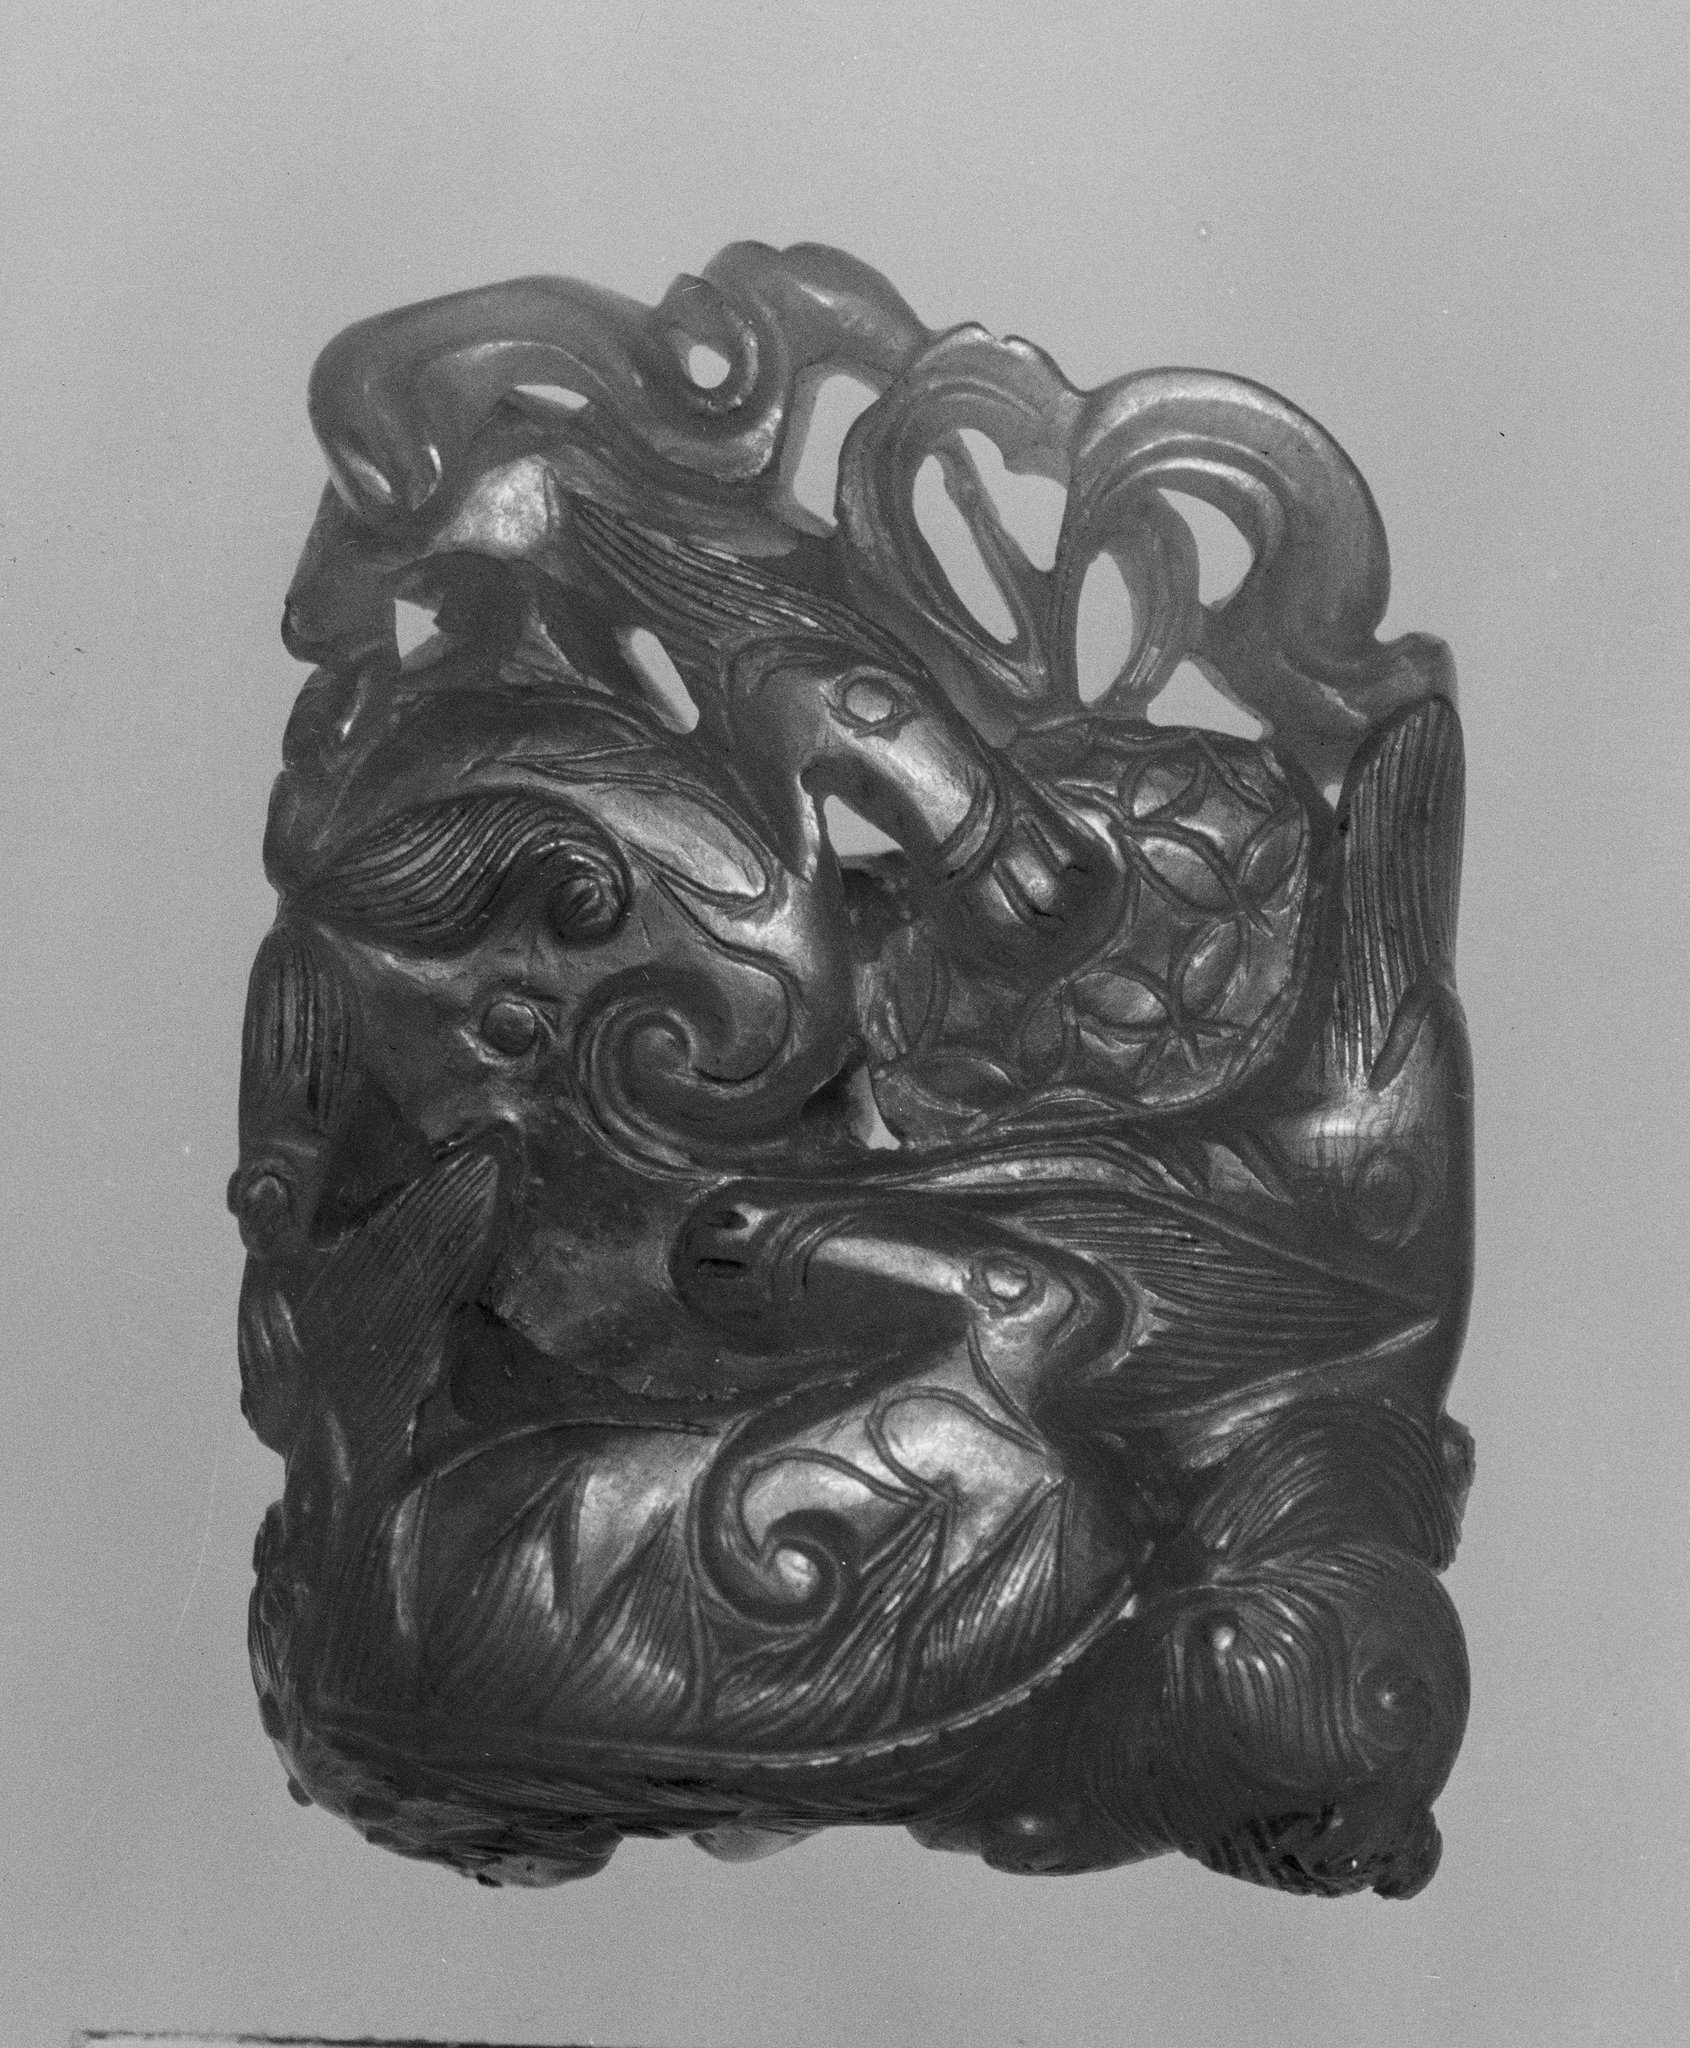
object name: paperweight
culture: chinese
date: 1736-1795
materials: jade